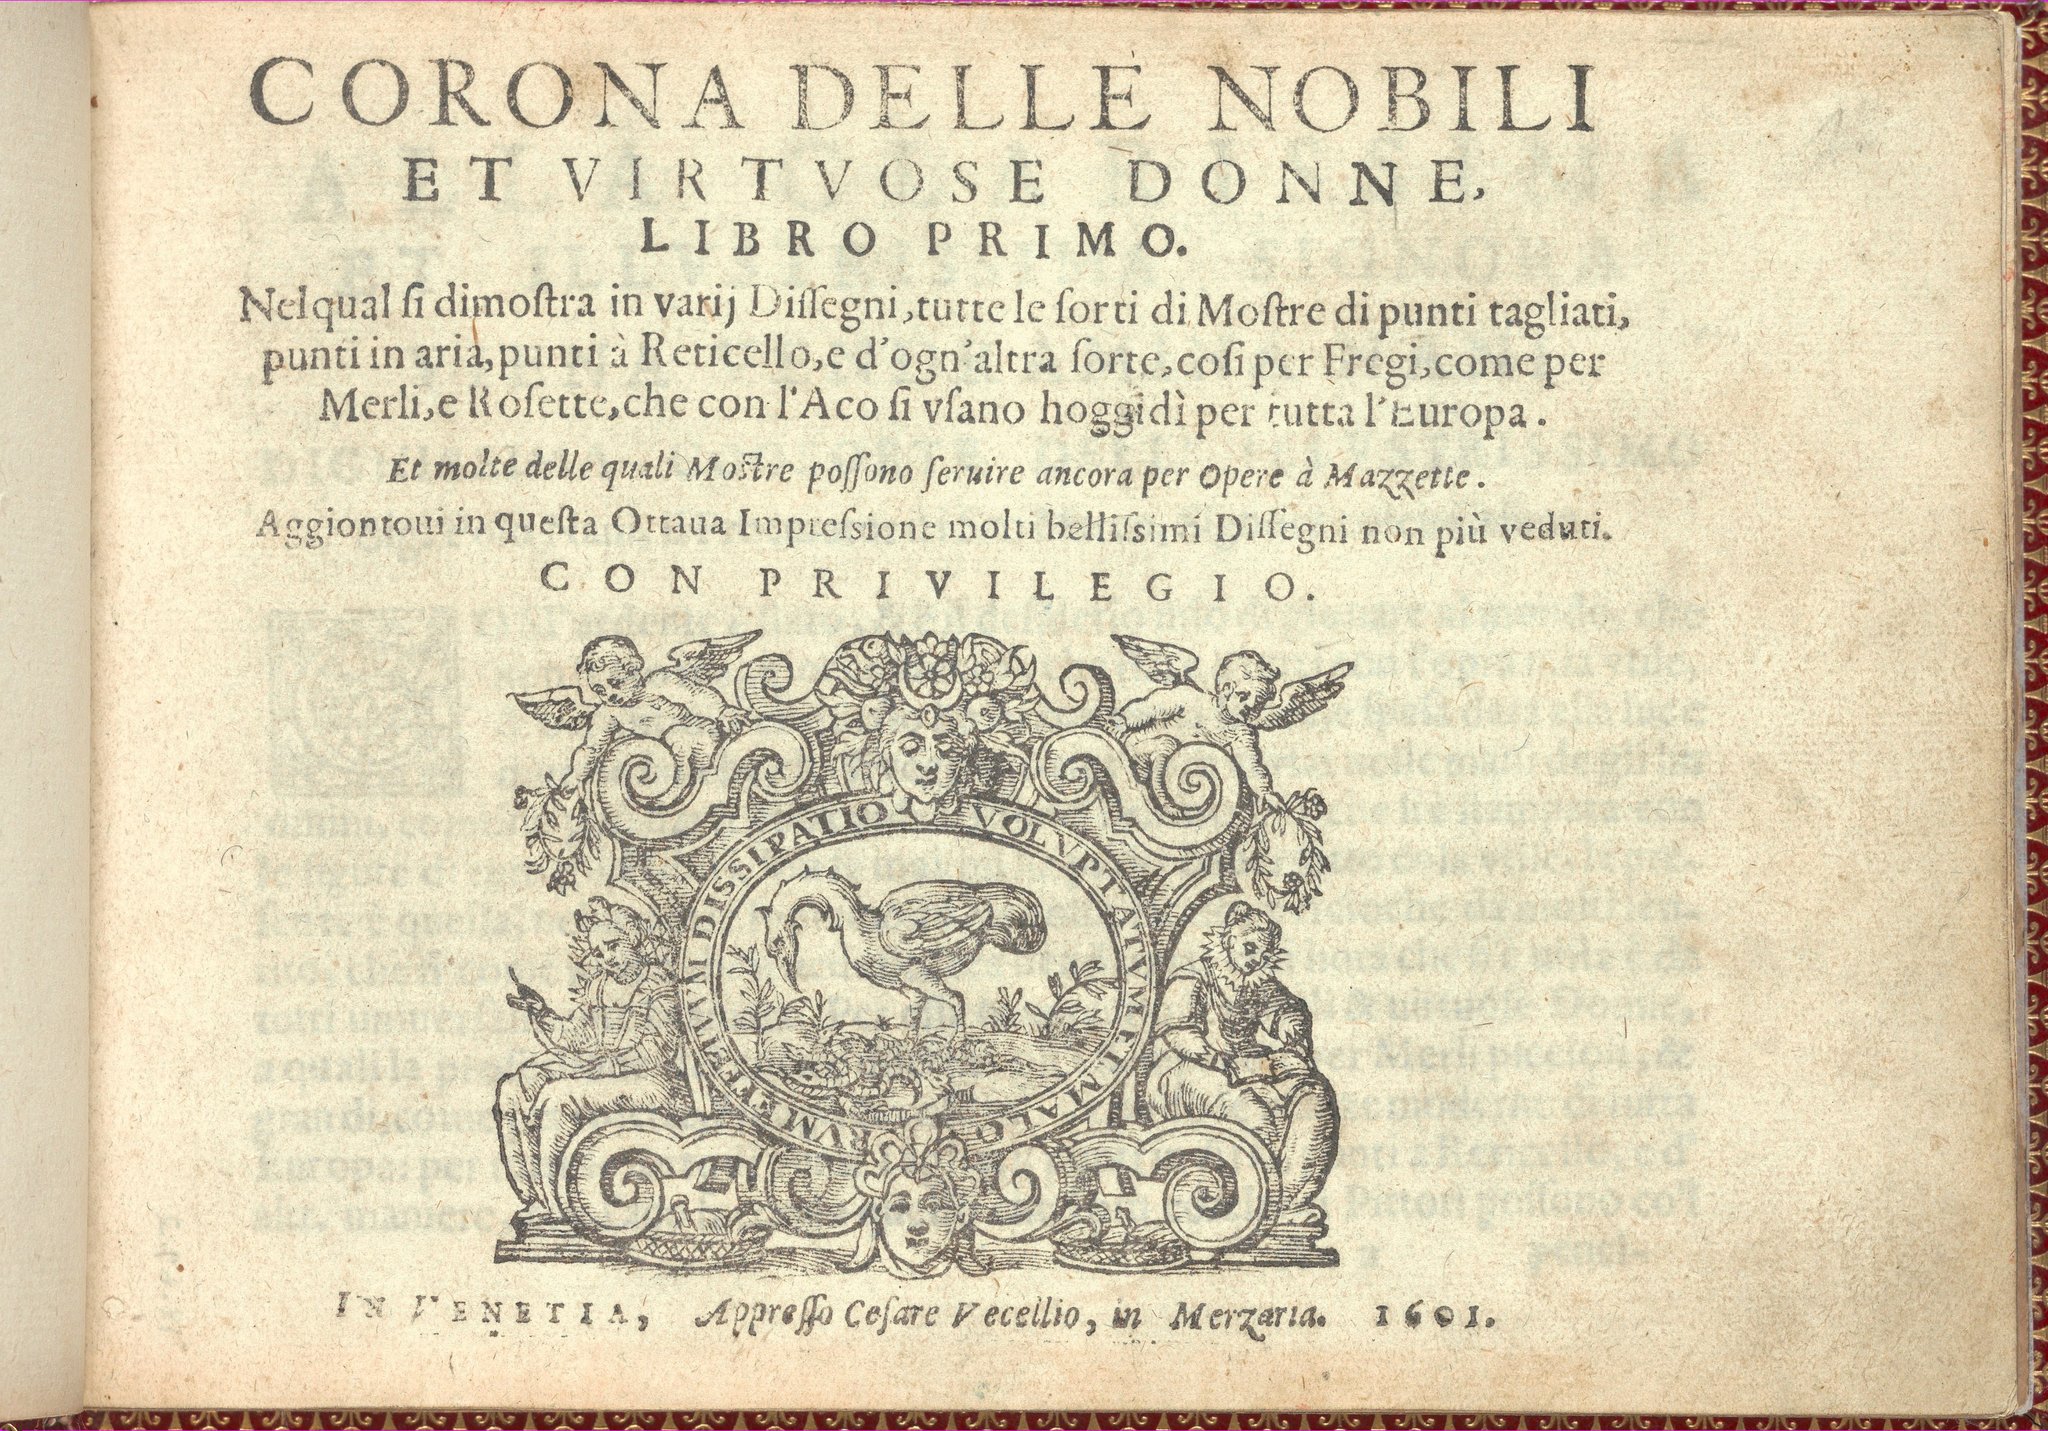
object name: book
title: Corona delle Nobili et Virtuose Donne: Libro I-IV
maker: cesare vecellio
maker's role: publisher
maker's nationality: italian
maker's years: 1521-1601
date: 1601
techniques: woodcut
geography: italy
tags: human figures,birds